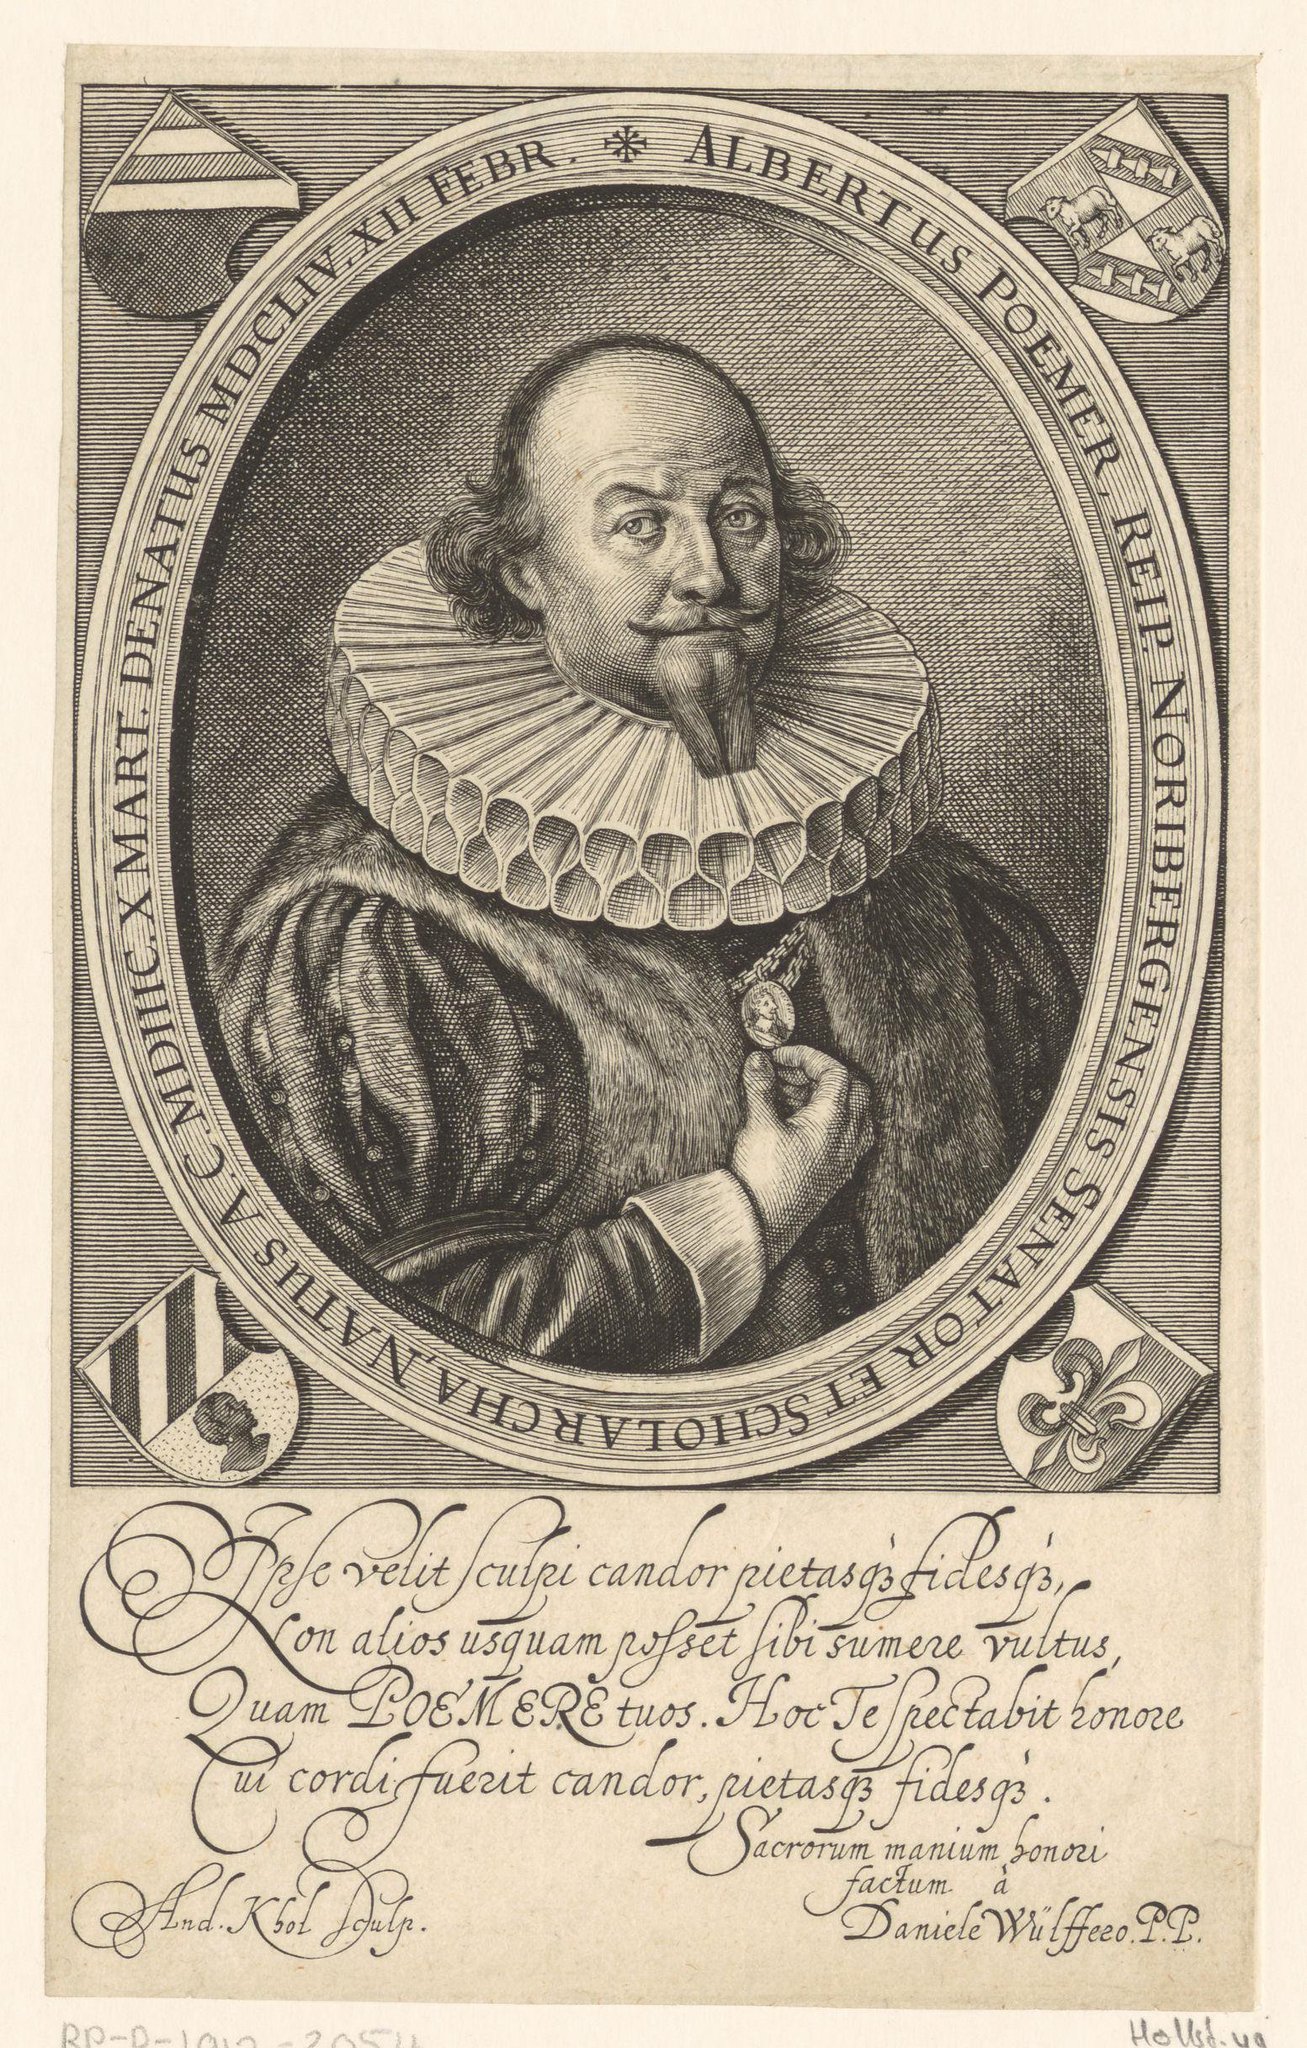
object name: print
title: Portret van Albrecht Pömer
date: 1654-1657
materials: paper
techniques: engraving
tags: historical persons, lawyer, attorney at law, counsellor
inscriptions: collector's mark: Lugt 2228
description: Tekst in het Latijn in de omlijsting en in de ondermarge.